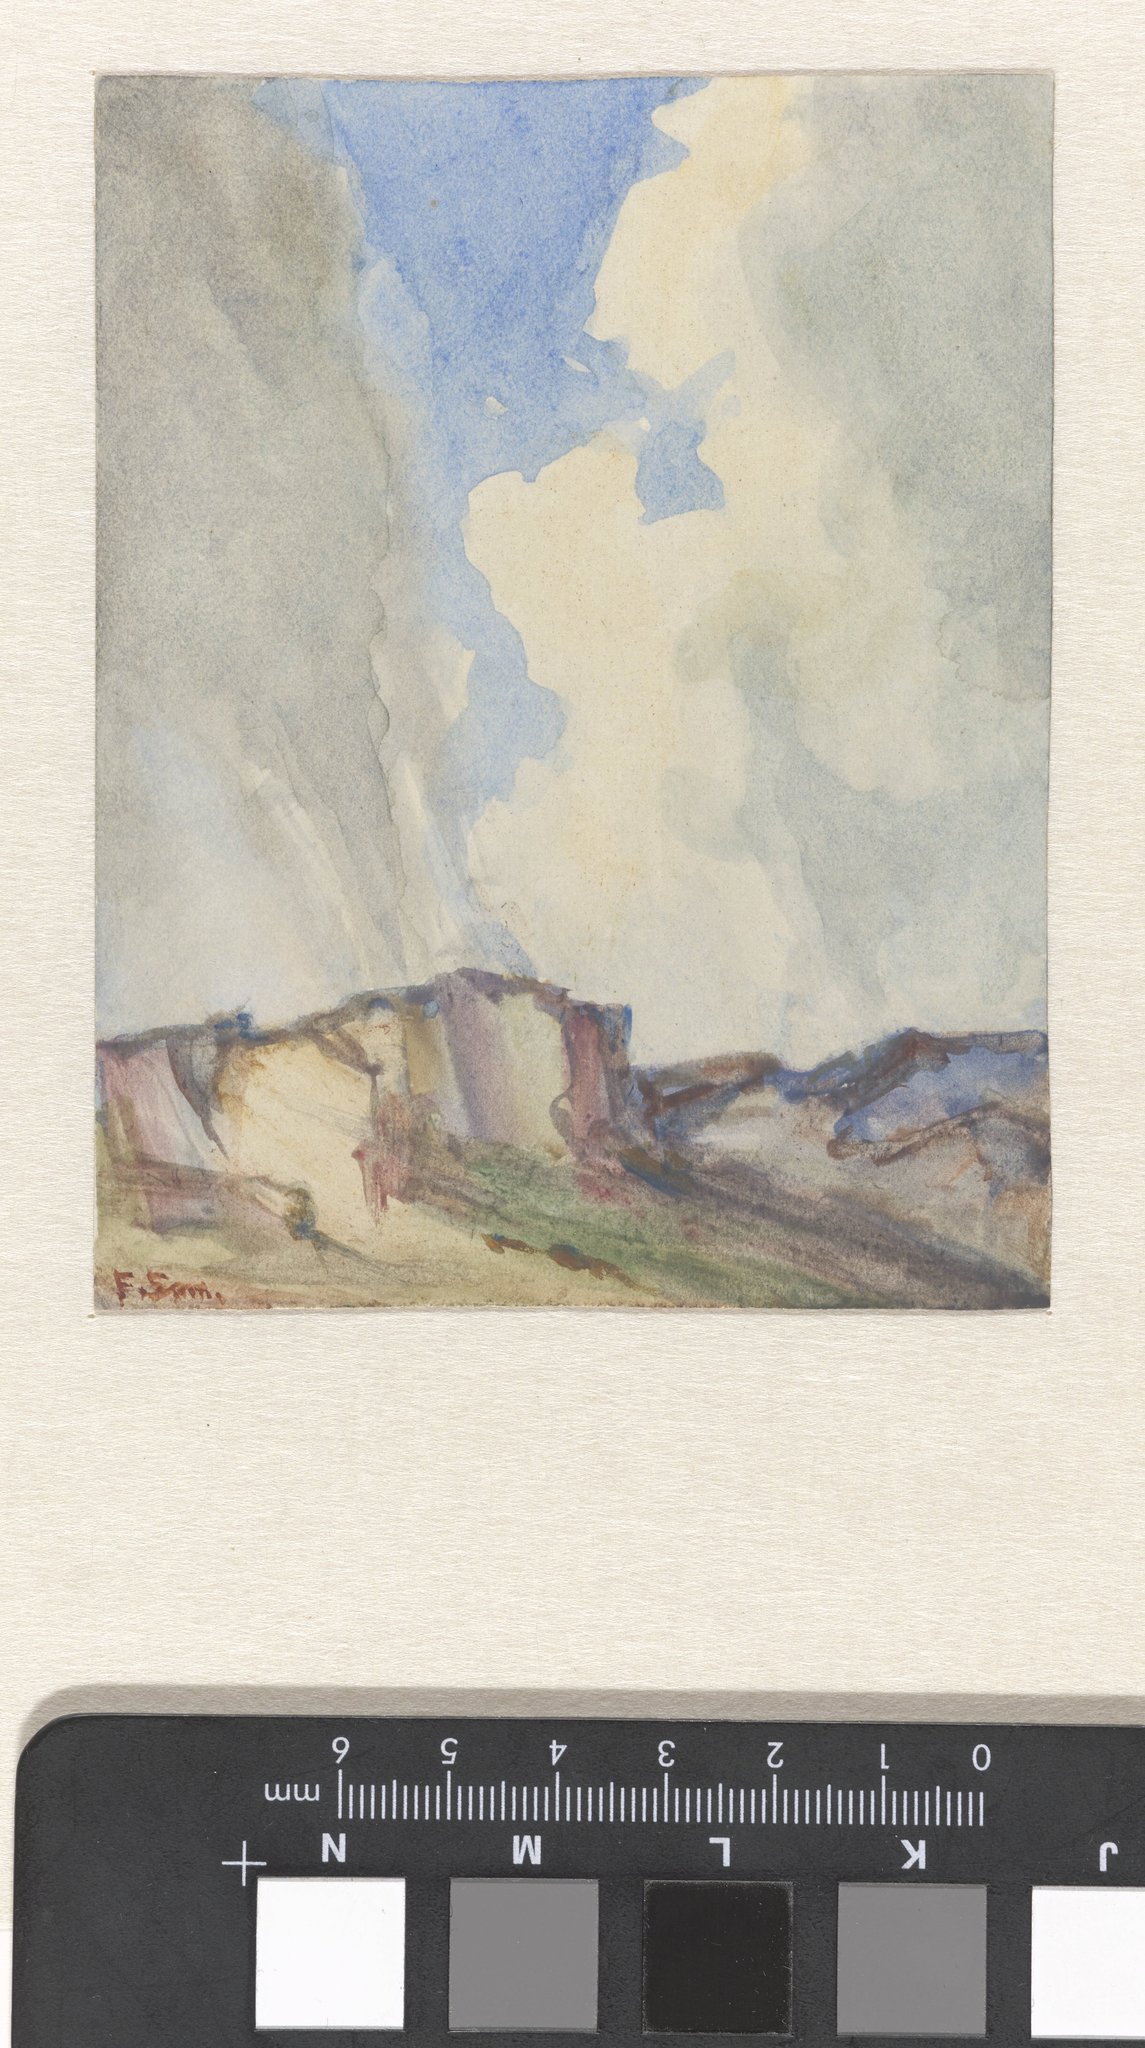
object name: drawing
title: Duinlandschap met zandafgraving onder stormachtige lucht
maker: frans smissaert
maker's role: draughtsman, print maker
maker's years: 1862-1944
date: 1872-1944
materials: paper, pencil, watercolor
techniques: brush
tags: dunes (sea not visible); in the dunes